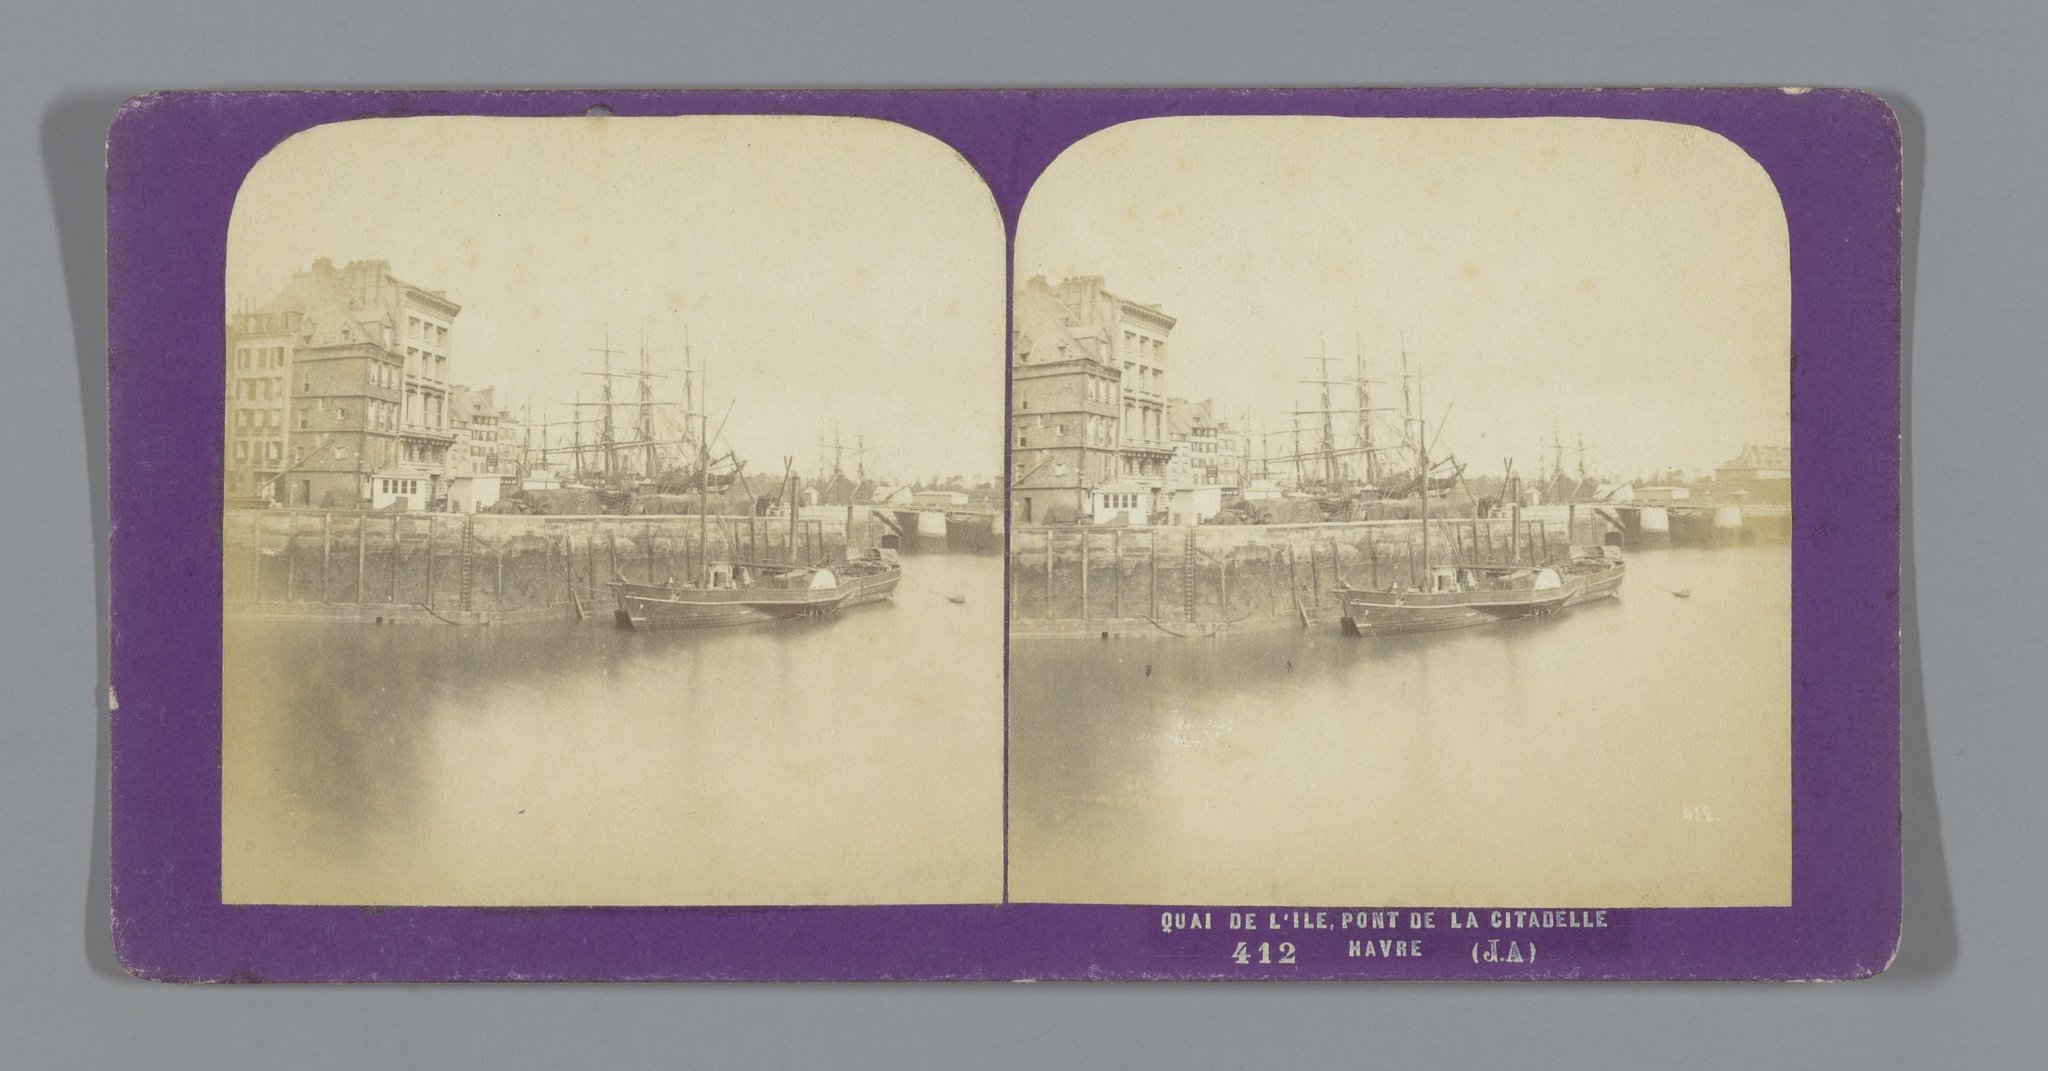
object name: stereograph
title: Quai de l'Ile, pont de la Citadelle, Havre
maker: jean andrieu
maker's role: fotograaf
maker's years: 1816-1872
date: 1862-1876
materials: cardboard, photographic support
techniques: albumen print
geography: le havre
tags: ships (in general), pier, quay, wharf, le havre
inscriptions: number: ‘412’